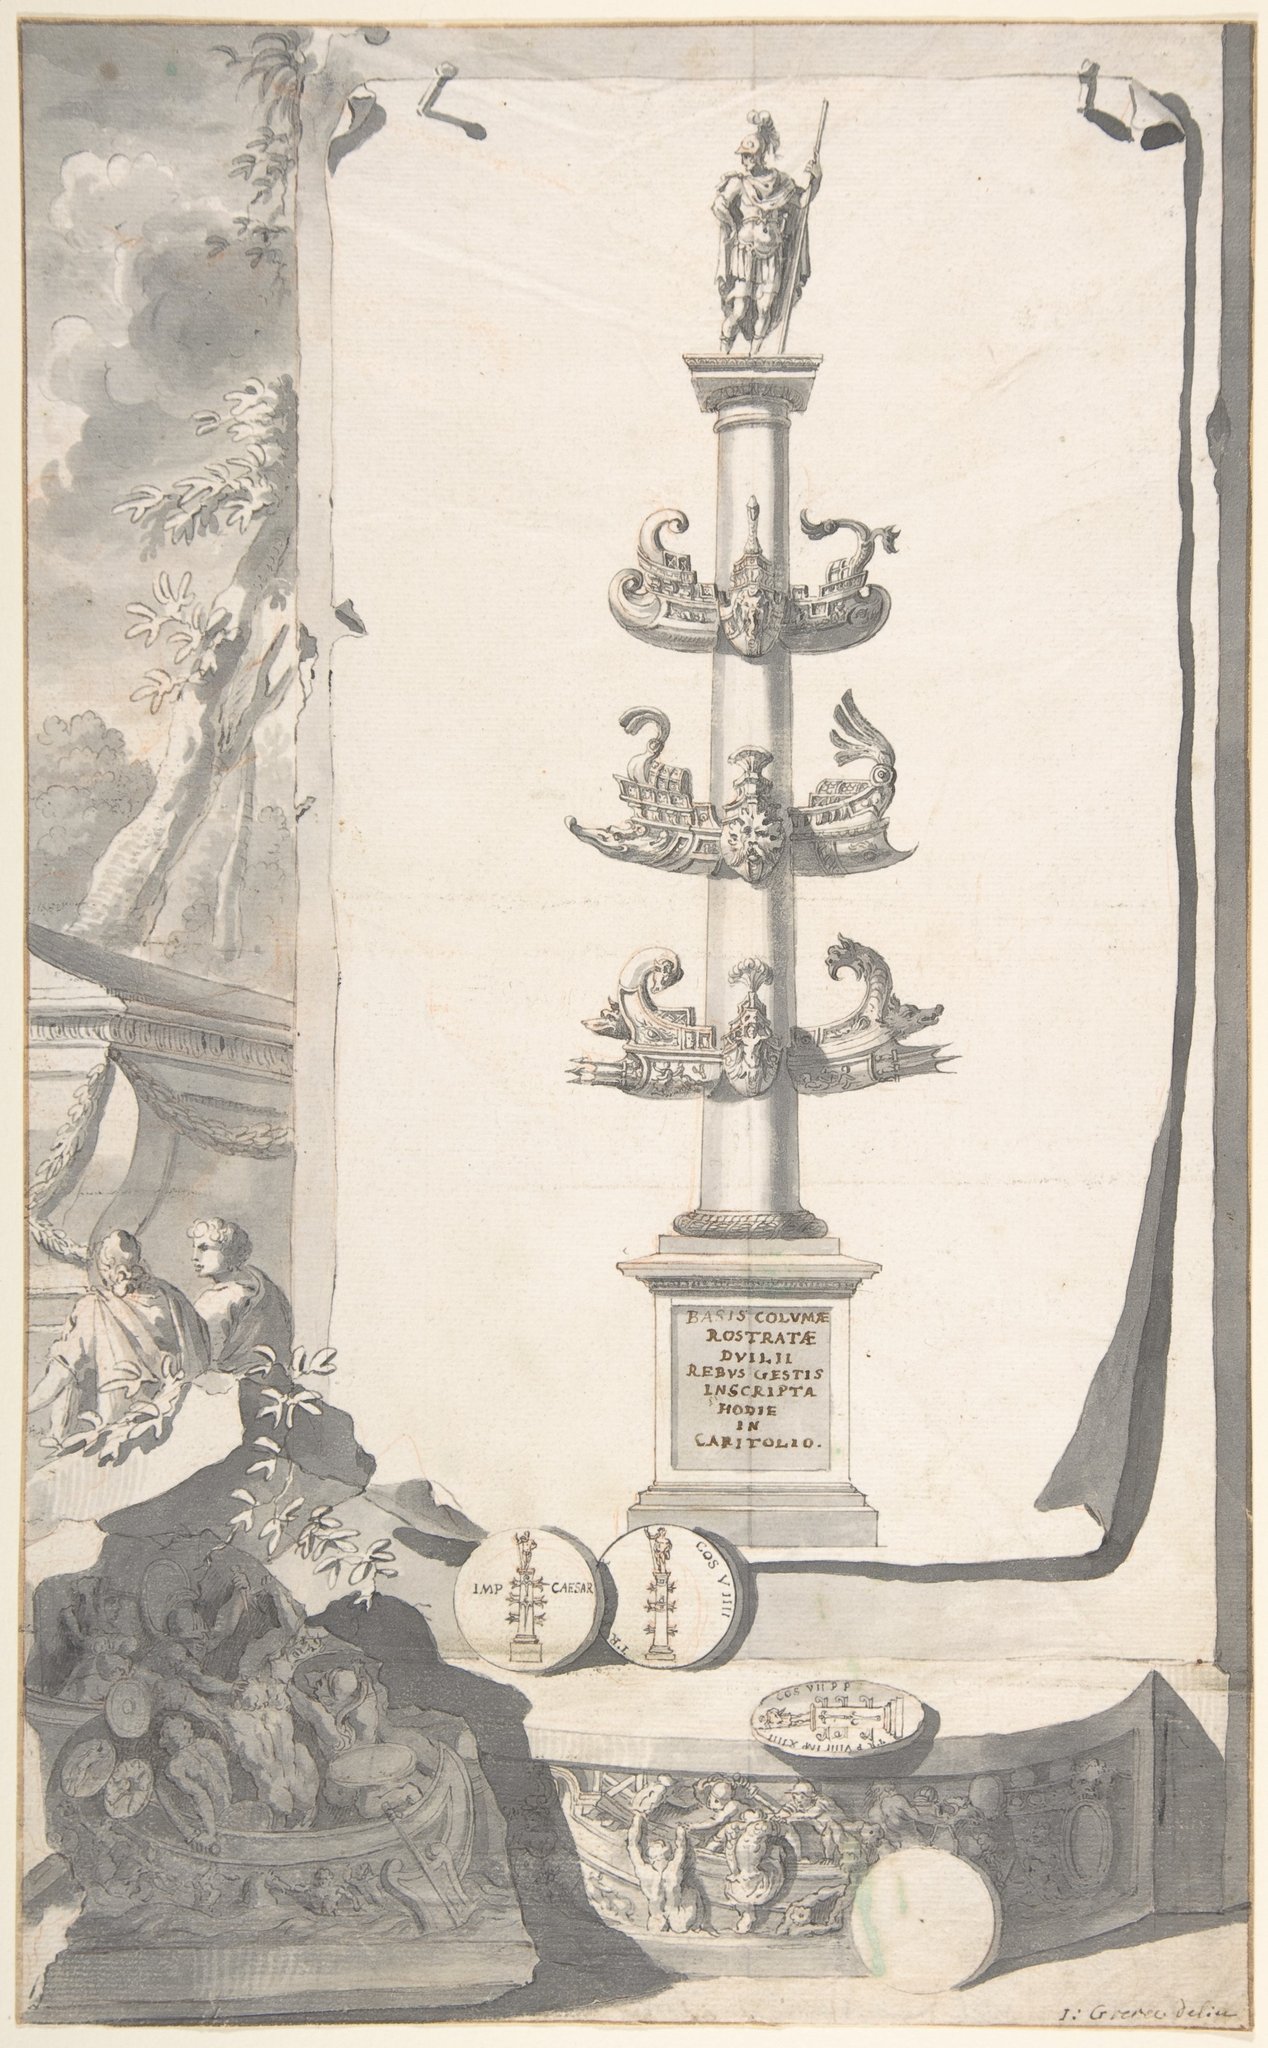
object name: drawing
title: A Reconstruction of the Base of the Column Rostrata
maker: jan goeree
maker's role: artist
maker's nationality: dutch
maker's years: 1670-1731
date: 1704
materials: chalk, ink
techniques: brush, pen, wash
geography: italy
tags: columns